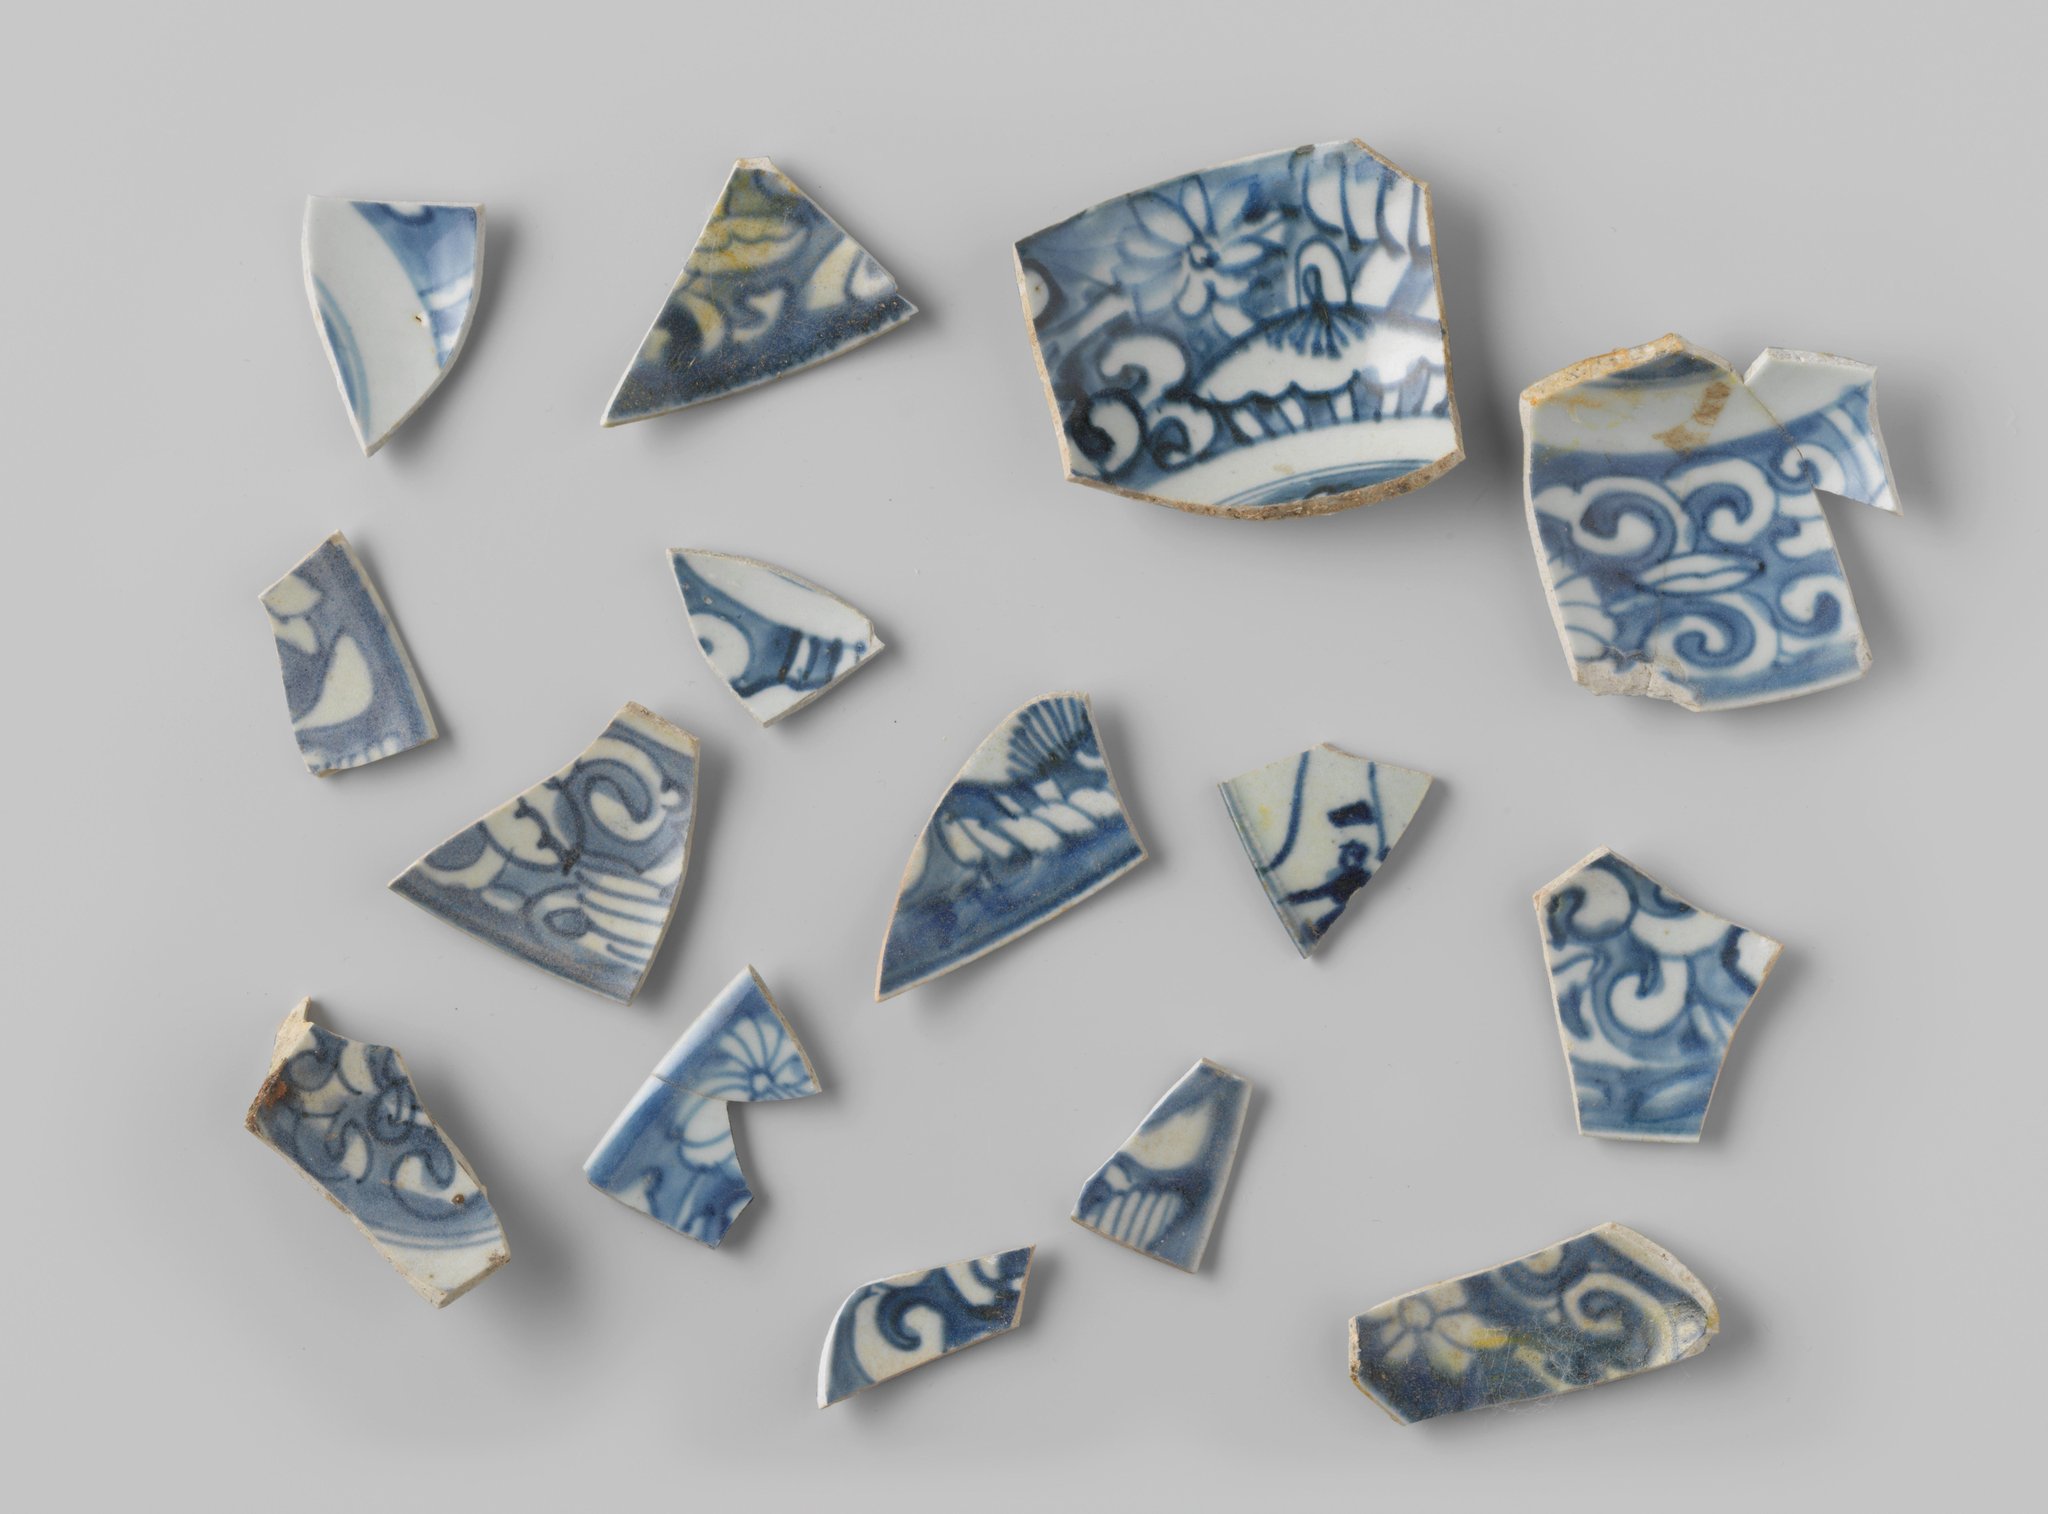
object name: sherd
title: Scherven porselein uit V.O.C.-schip de 'Witte Leeuw'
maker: Anonymous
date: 1613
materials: porcelain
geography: jingdezhen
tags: verenigde oostindische compagnie, sint-helena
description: Scherven porselein uit V.O.C.-schip de 'Witte Leeuw'.